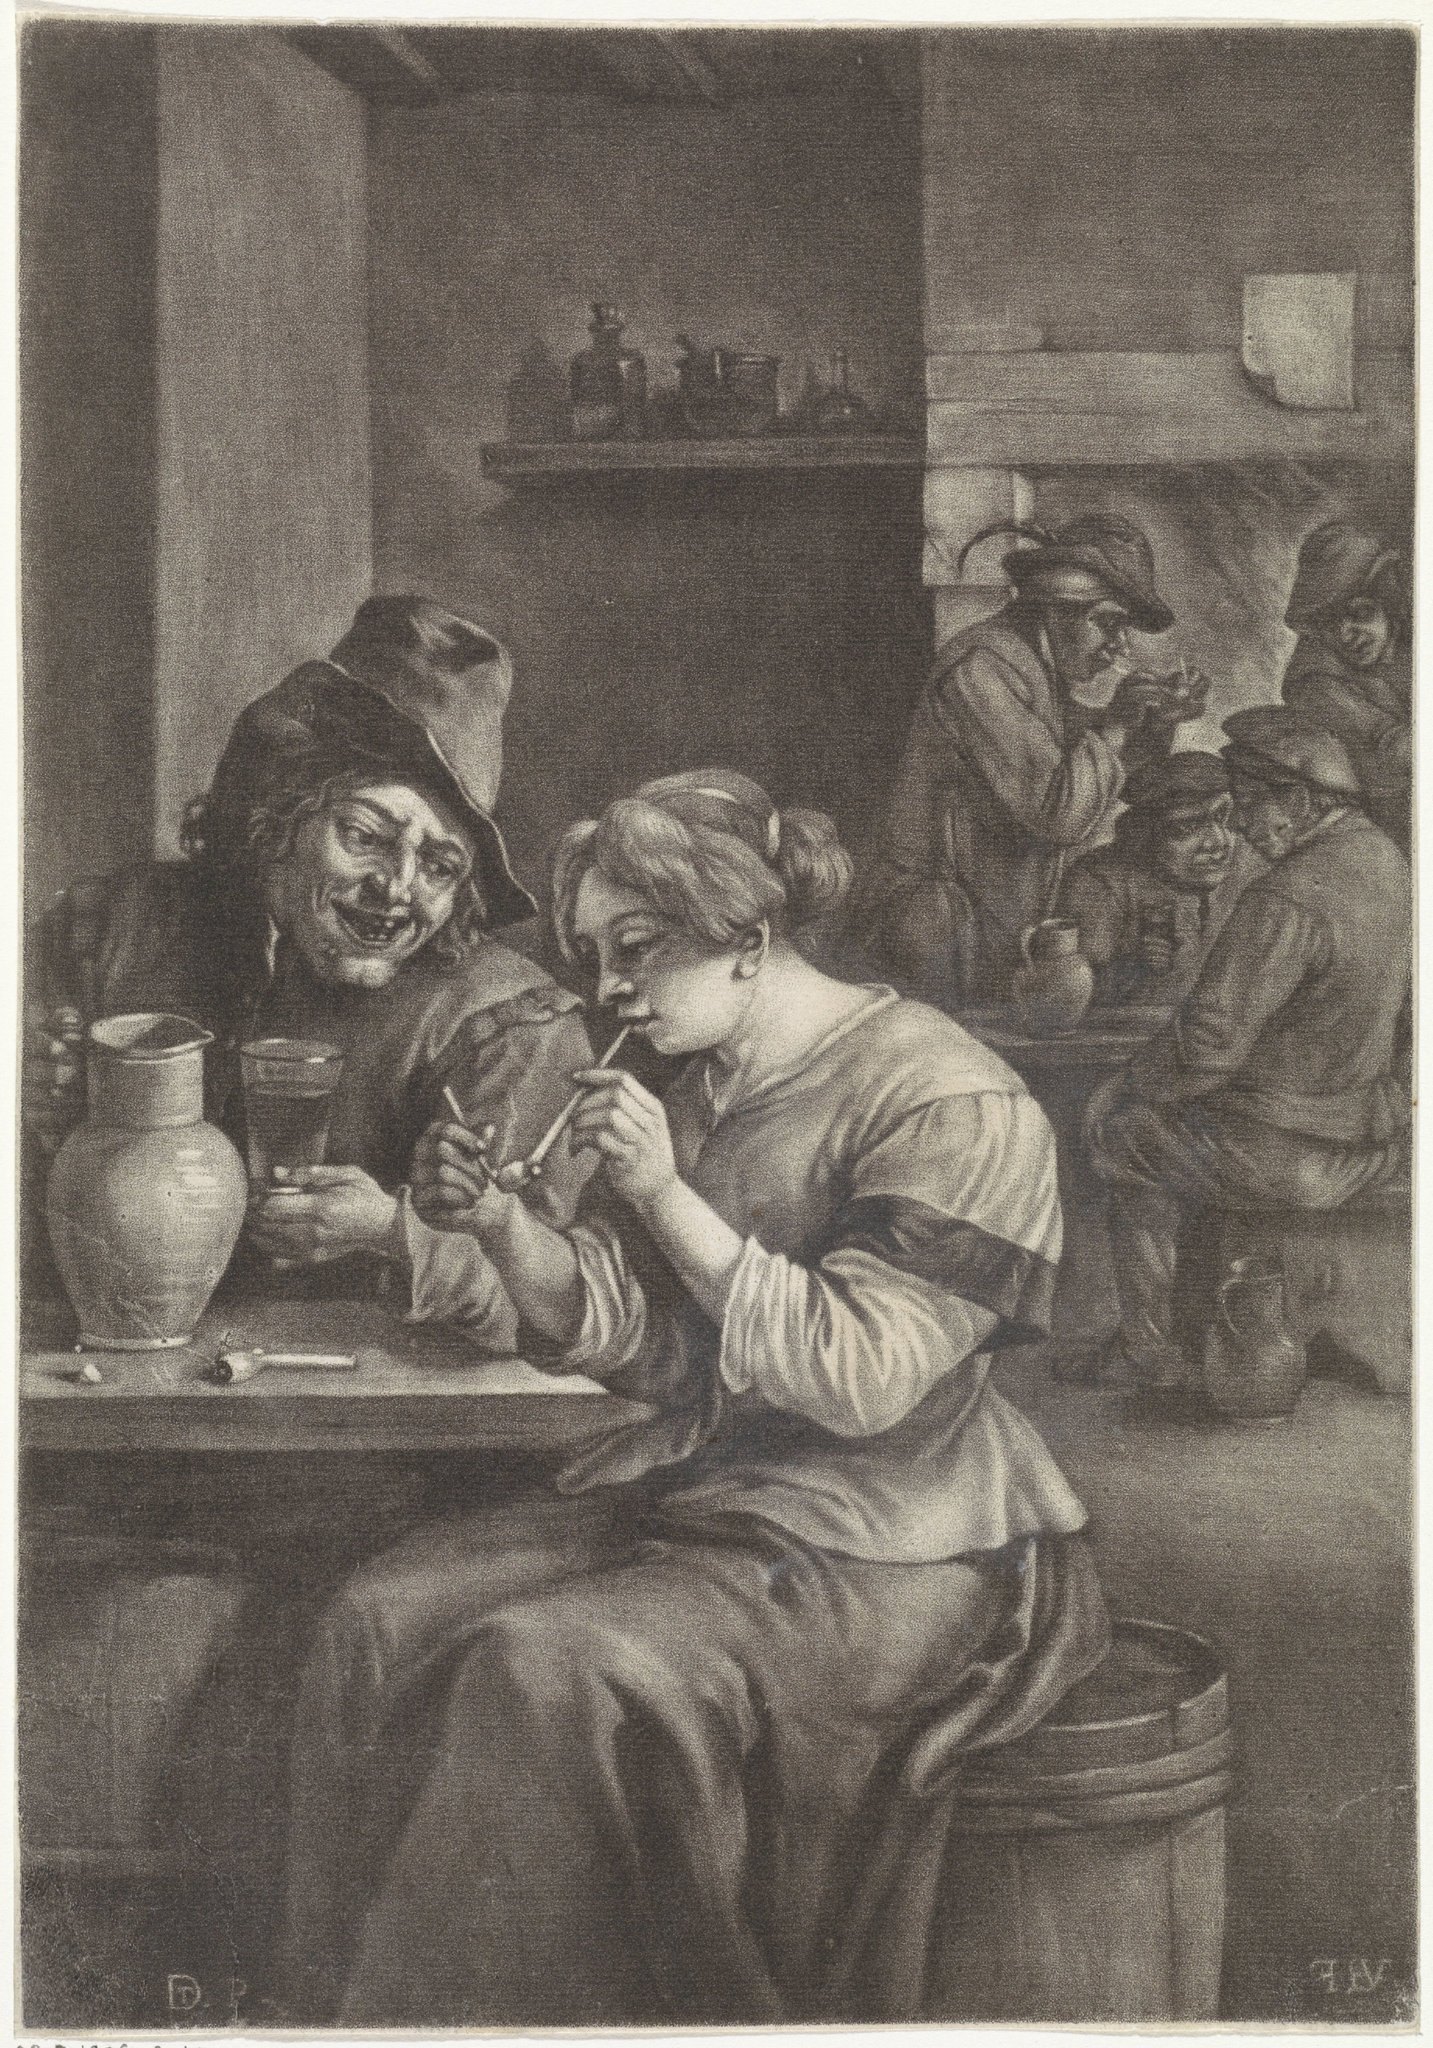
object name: print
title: Vrouw steekt haar pijp aan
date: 1659-1689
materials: paper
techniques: mezzotint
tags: inn, coffee-house, public house, etc., pipe ~ tobacco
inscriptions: collector's mark: Lugt 2228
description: In een herberg zit een vrouw naast een boer aan een tafeltje. Ze steekt haar pijp aan. Op de achtergrond vier drinkende en rokende boeren bij de haard.